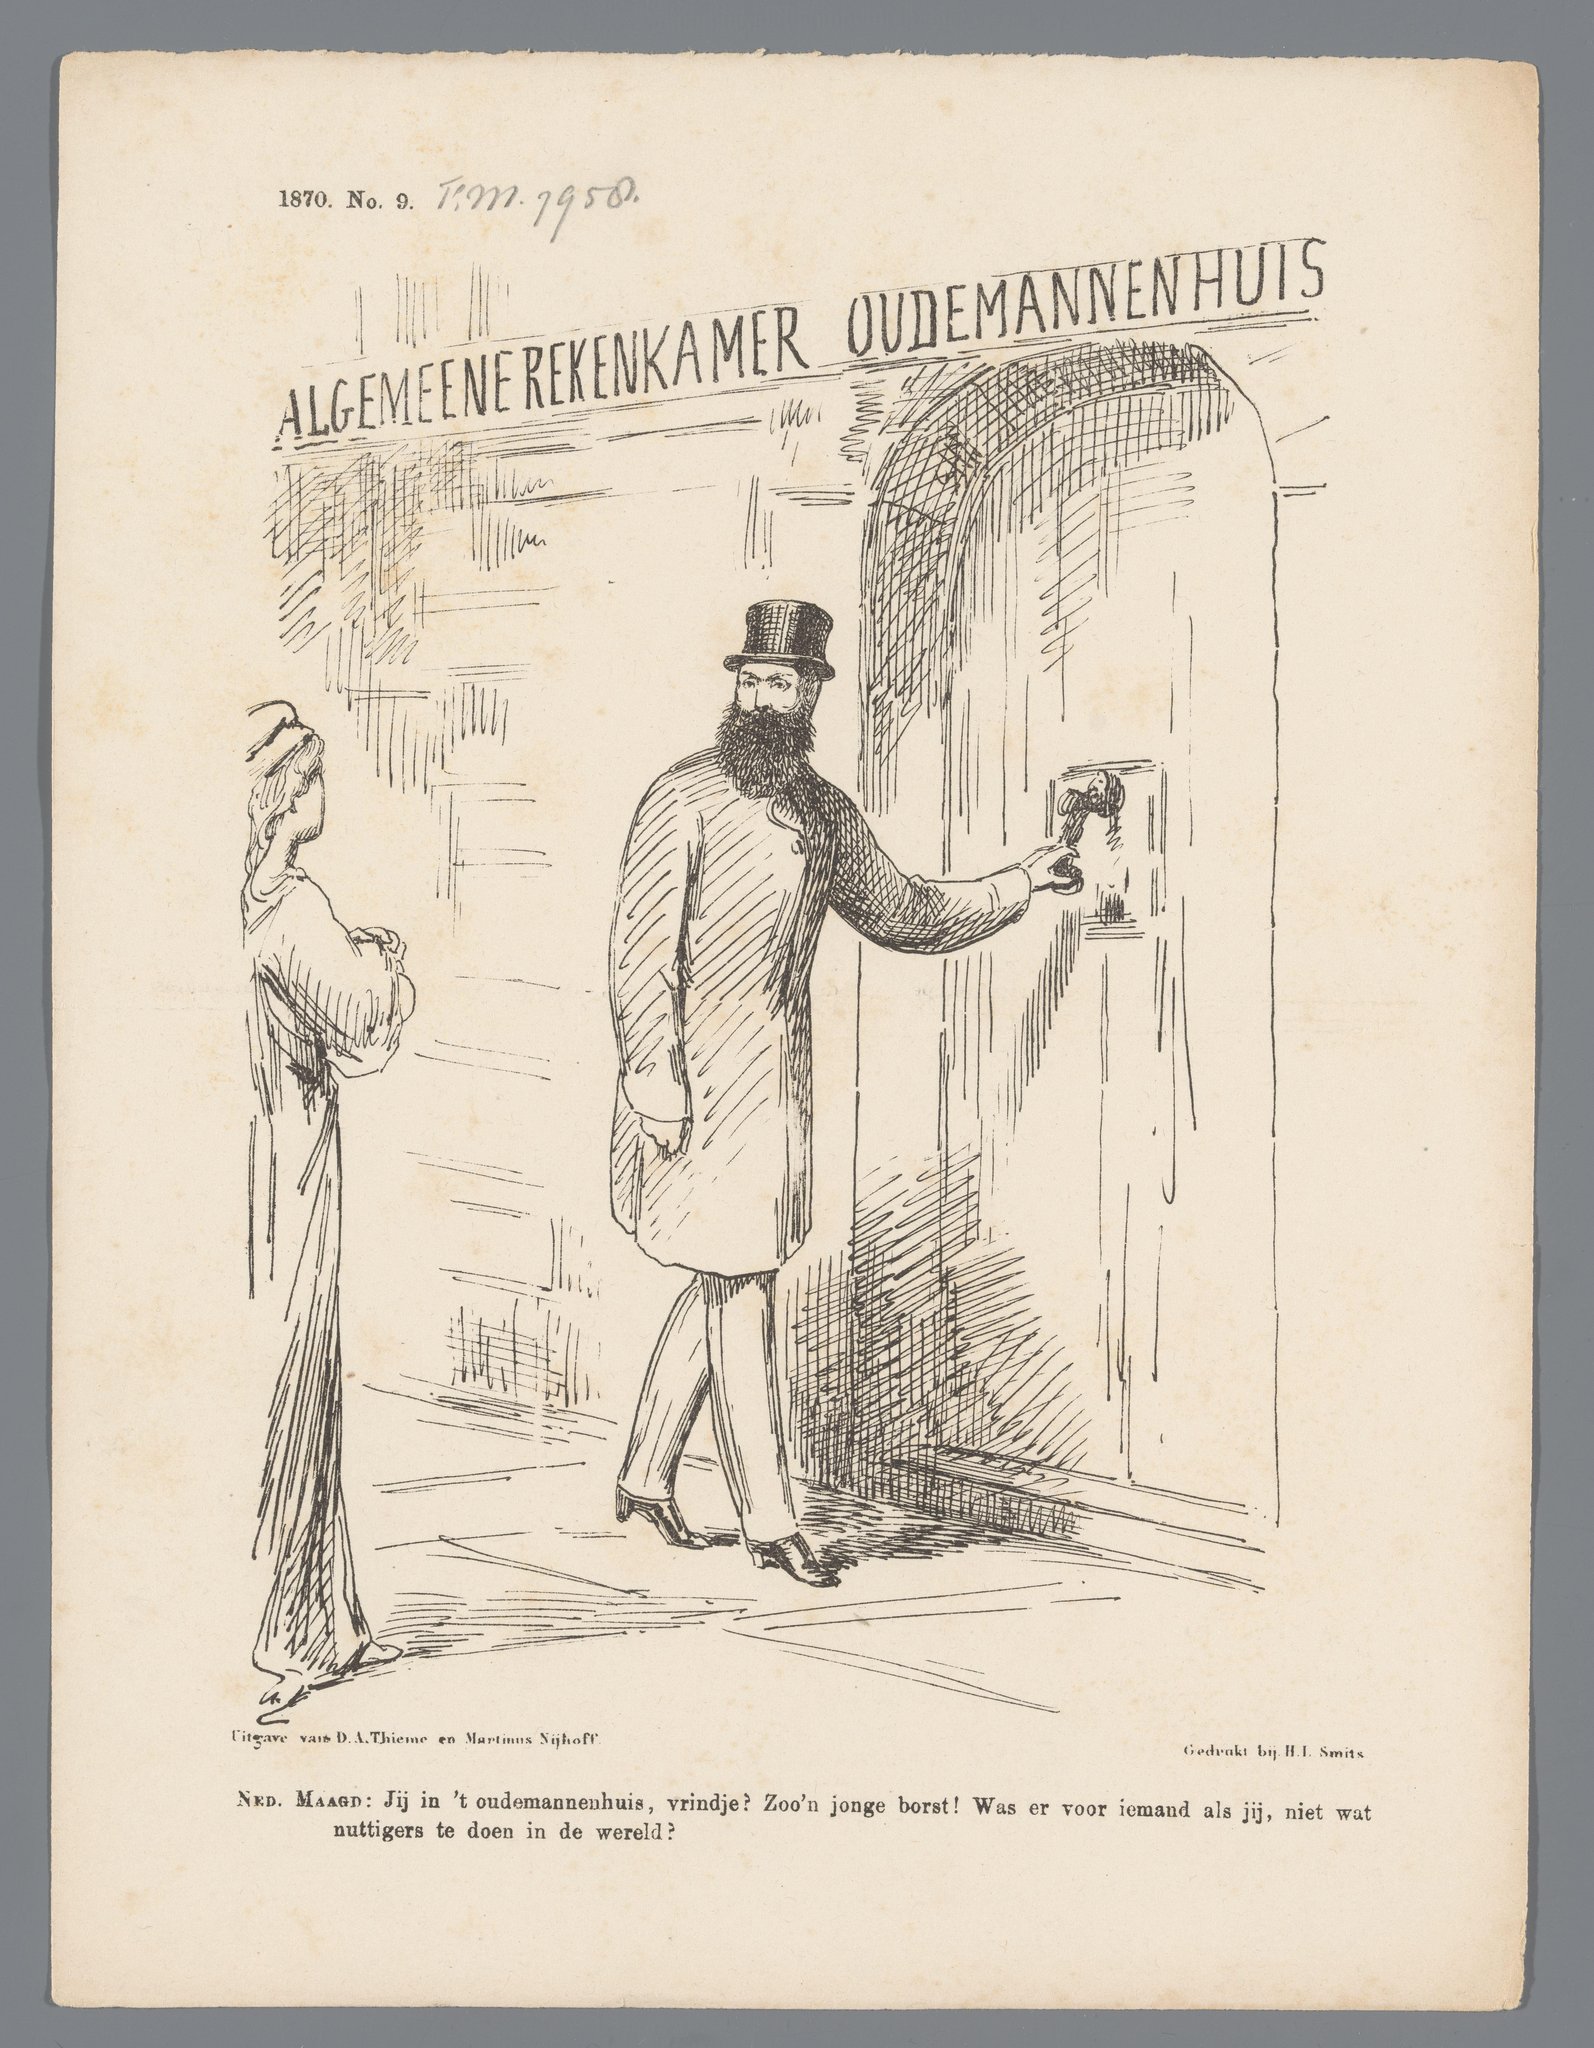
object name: print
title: Spotprent op jhr. Van Karnebeek, 1870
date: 1870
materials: paper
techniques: lithograph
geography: netherlands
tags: personifications of countries, nations, states, districts, etc.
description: Spotprent op jhr. Van Karnebeek die bij de Algemene Rekenkamer (het Oudemannenhuis genoemd) gaat werken. De Nederlandse Maagd spreekt hem hierop aan. Plaat verschenen bij het weekblad De Nederlandsche Spectator, nr. 9, 1870.